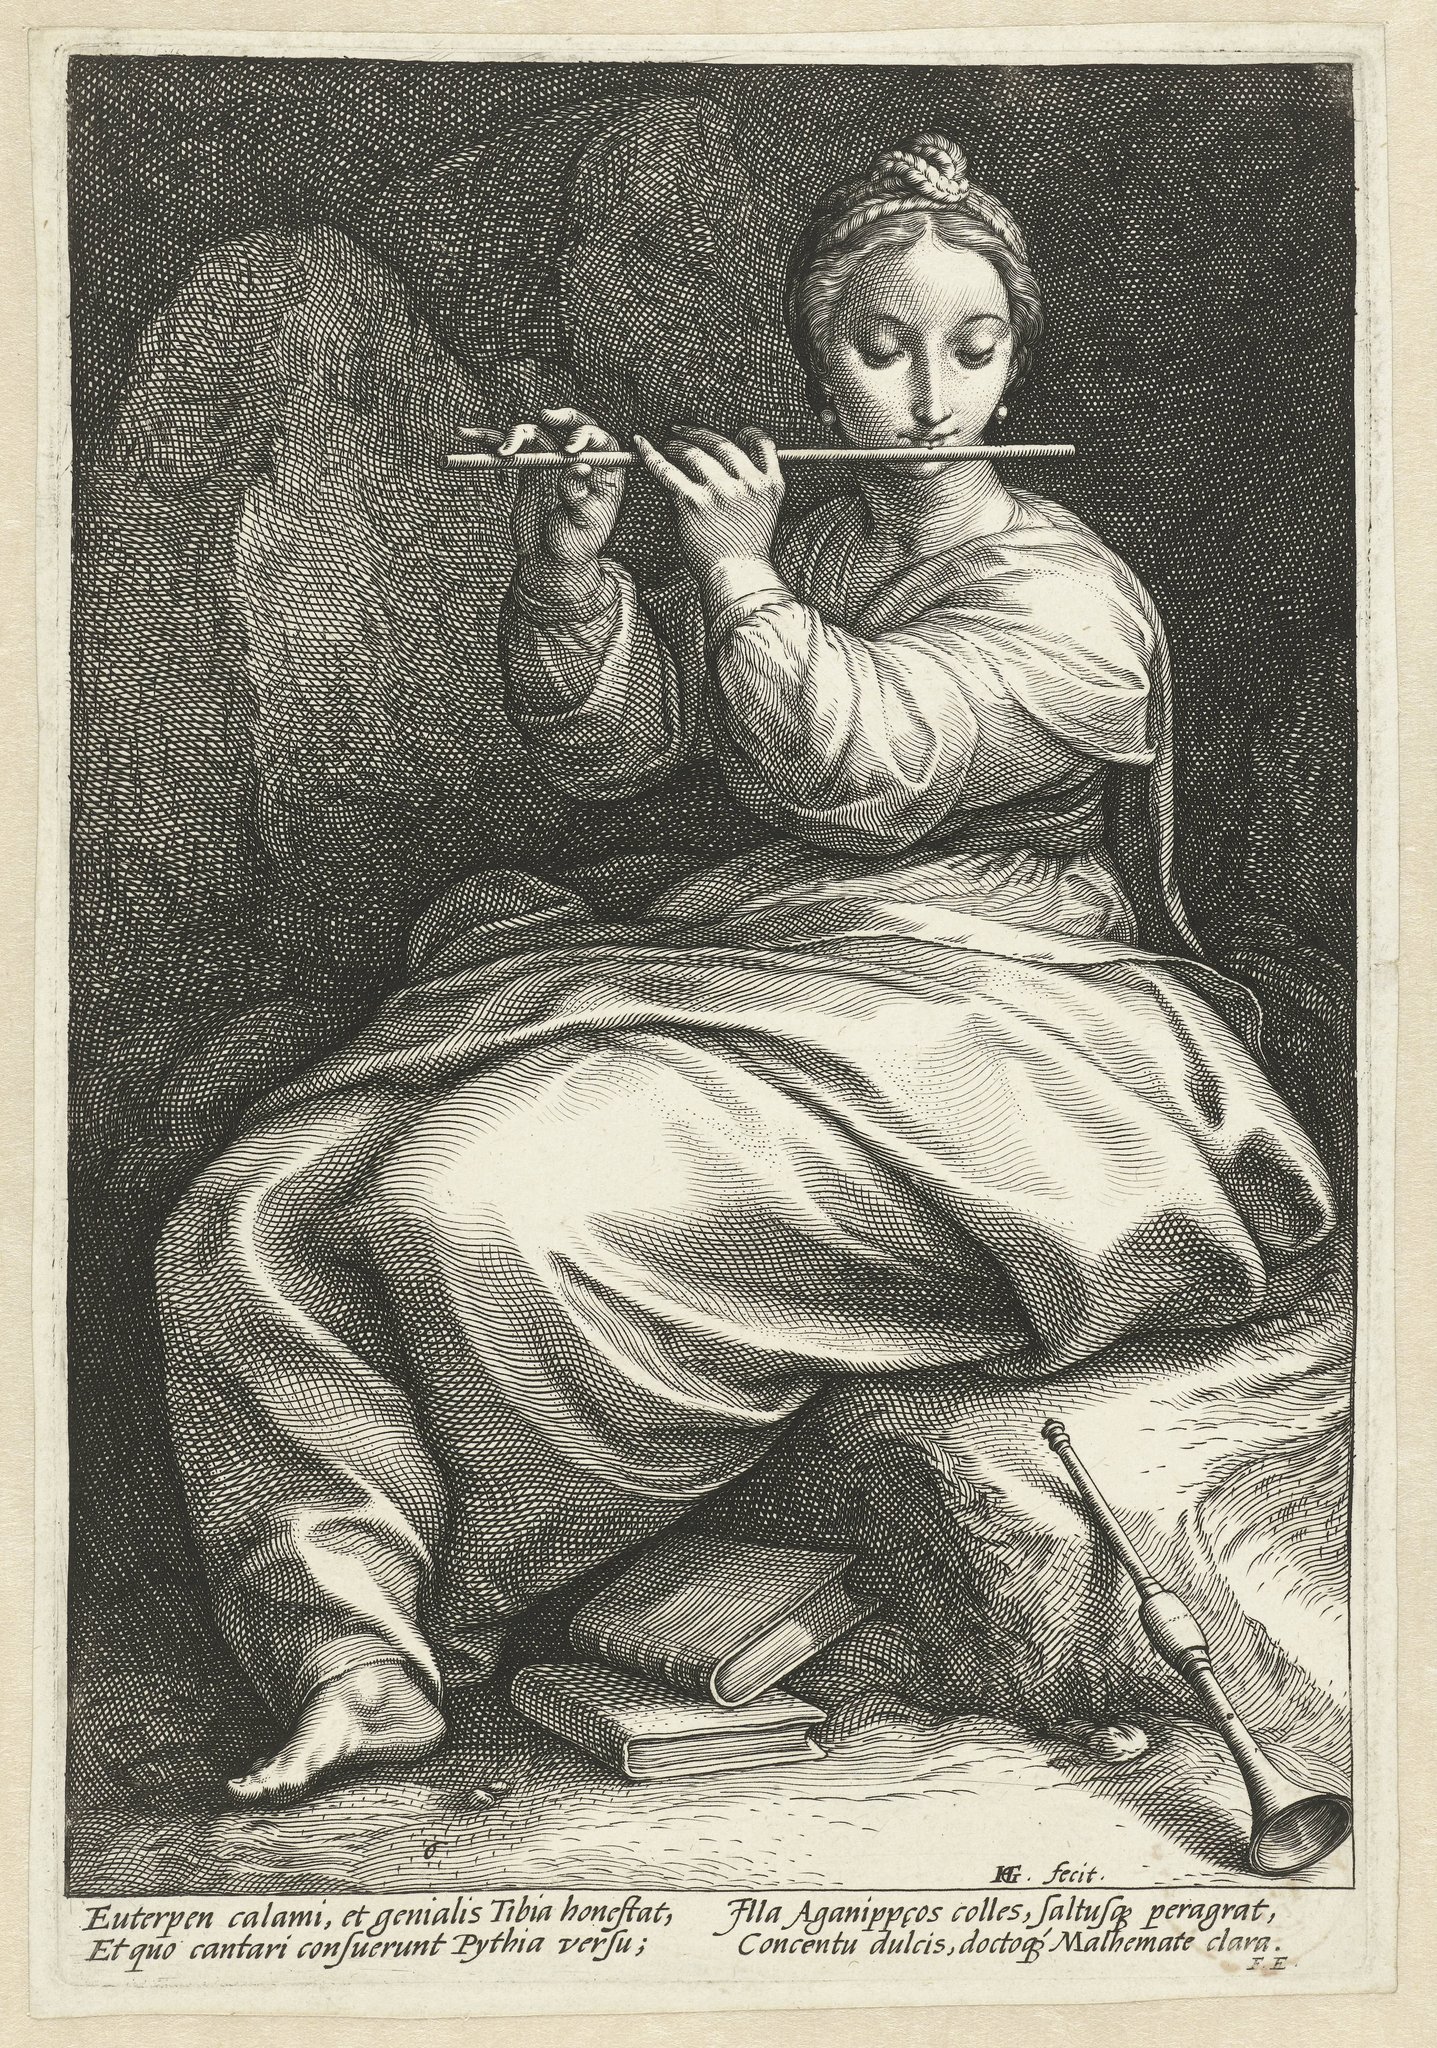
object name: print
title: Euterpe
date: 1592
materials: paper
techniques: engraving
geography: haarlem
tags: euterpe (one of the muses); 'euterpe' (ripa)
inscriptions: signature: ‘HG. fecit’, signature: ‘F.E.’, collector's mark: Lugt 240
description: Een serie van negen muzen. Vier regels Latijn van Franco Estius in marge onder prent.